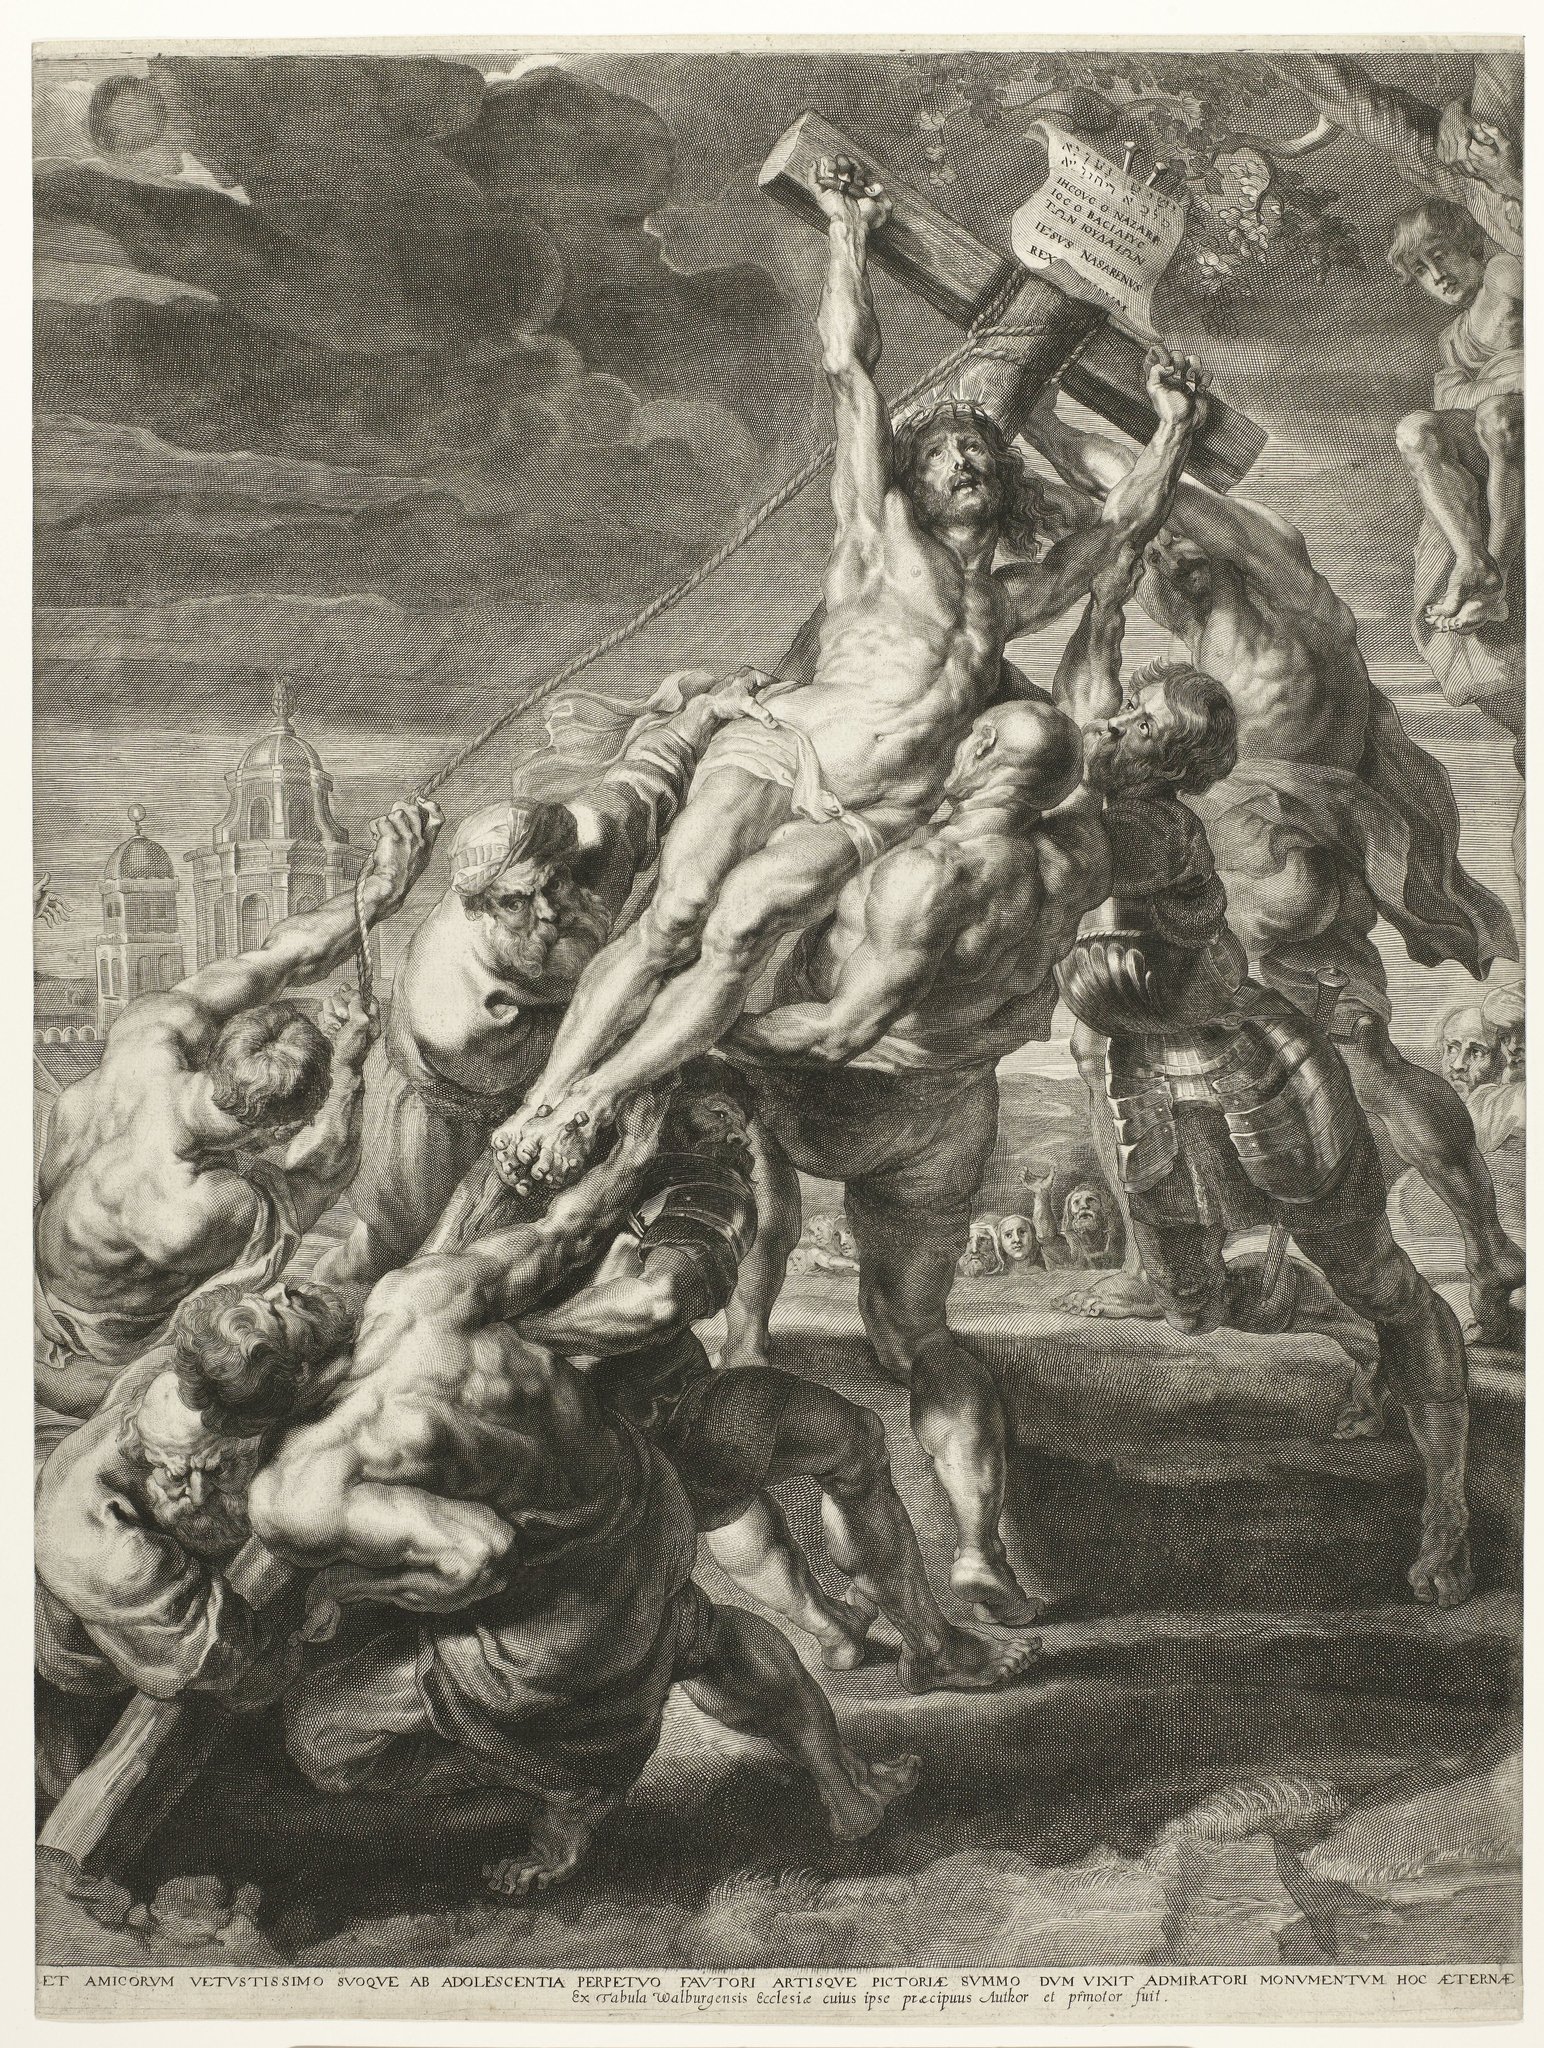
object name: print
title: Kruisoprichting, middelste deel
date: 1638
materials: linen, paper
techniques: engraving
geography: antwerp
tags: the erection of the cross: raising of the cross (without christ)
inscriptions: collector's mark: Lugt 240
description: Christus is aan het kruis genageld. Bovenaan hangt een papier met zijn naam in verschillende talen. Beulsknechten en soldaten zetten het kruis recht in de grond. Op de achtergrond is te zien hoe het volk toekijkt. In de marge een tweeregelig onderschrift met een opdracht in het Latijn.